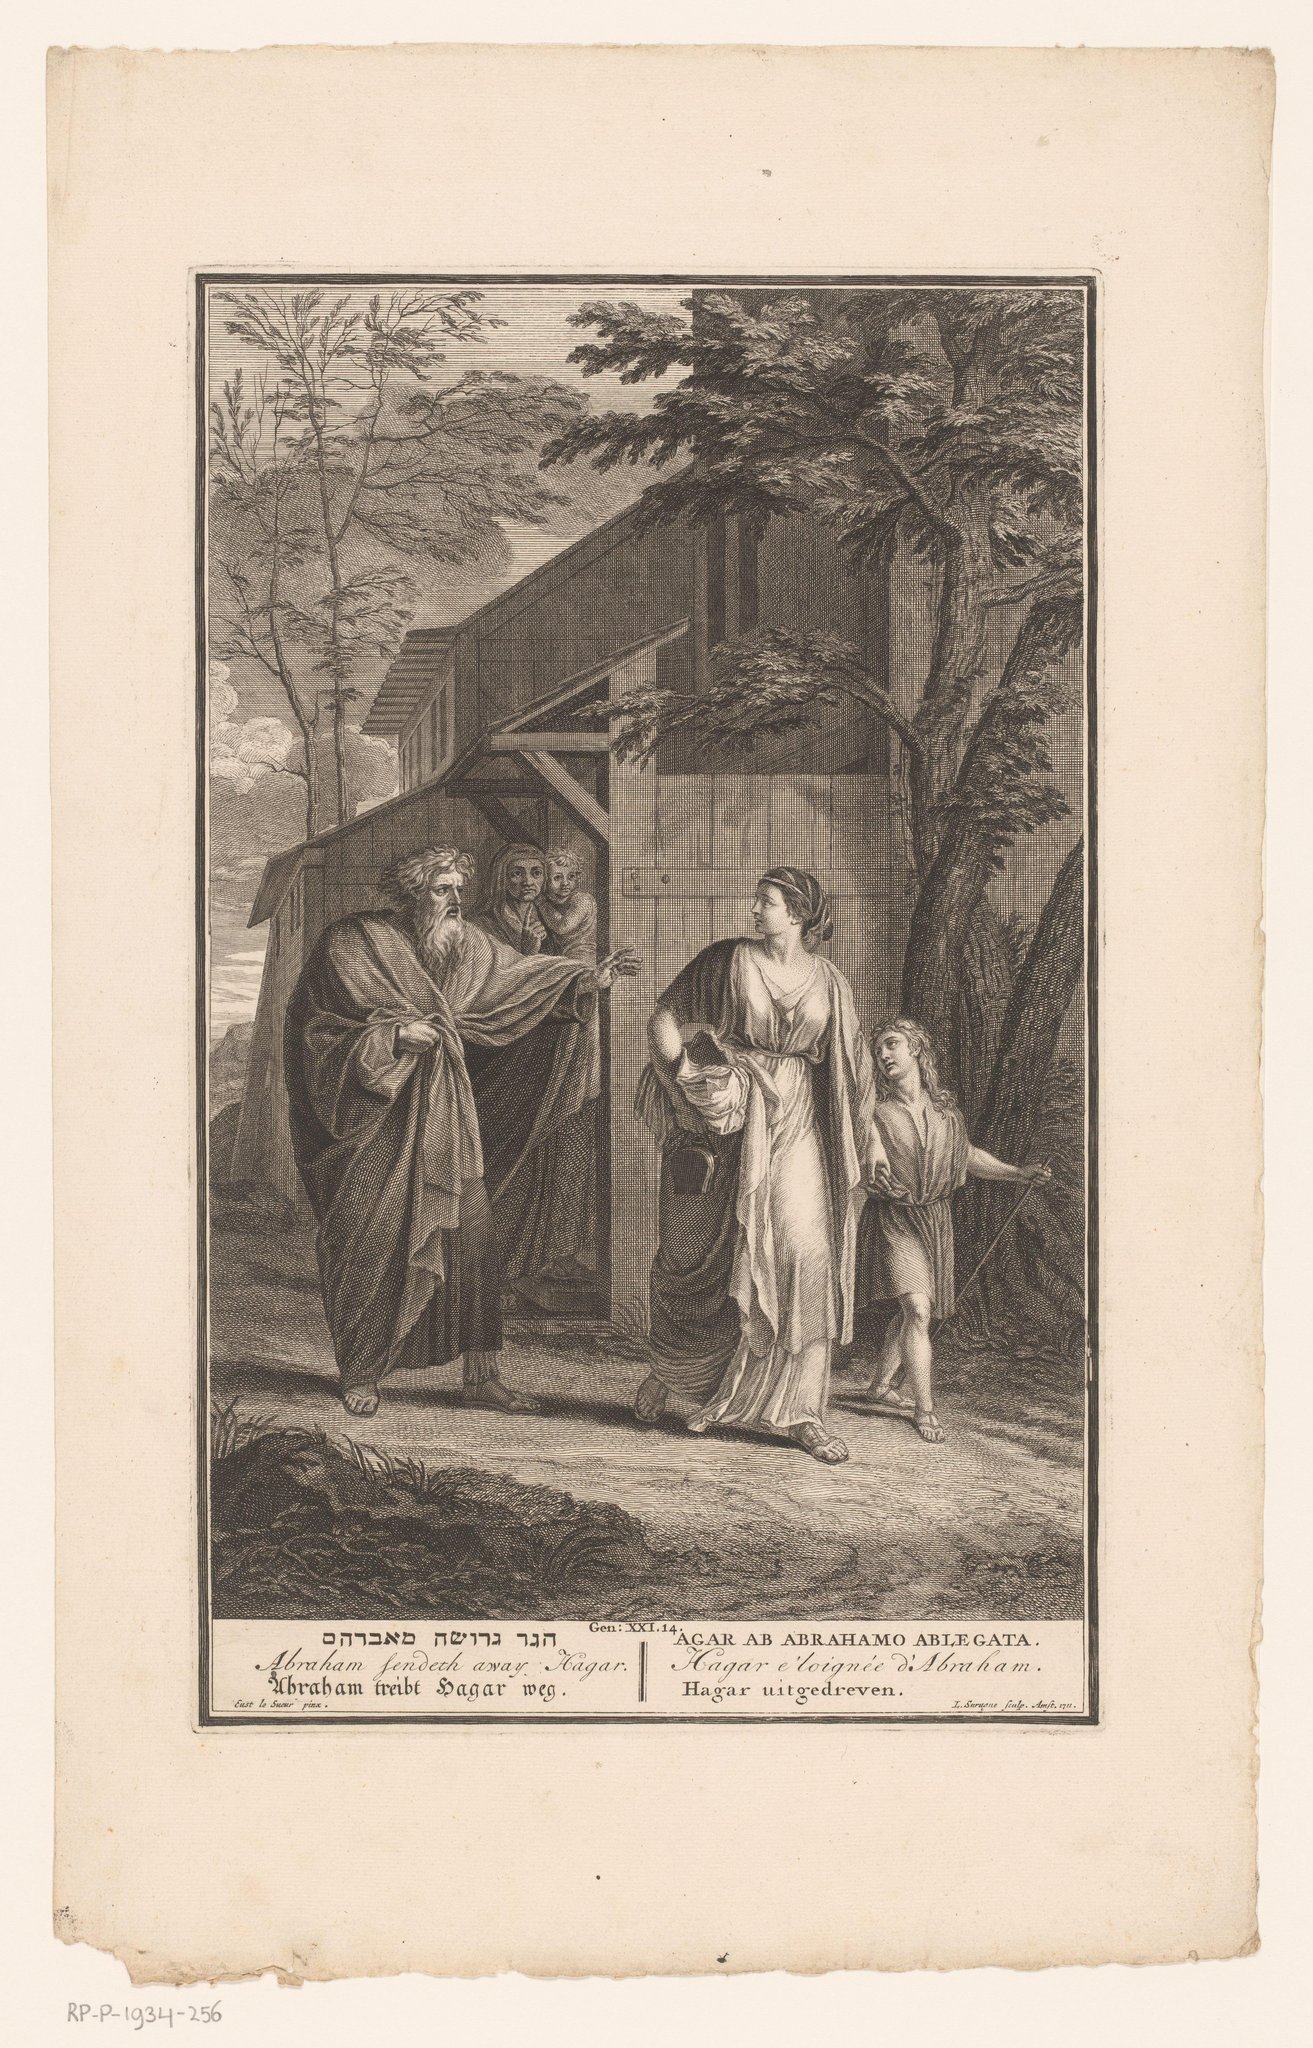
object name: print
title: Scènes uit het Oude en Nieuwe Testament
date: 1711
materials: paper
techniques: engraving, etching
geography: amsterdam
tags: hagar and ishmael (often with bow and arrow) depart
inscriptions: collector's mark: ‘Utrechts Fundatie huijs’, collector's mark: Lugt 2228